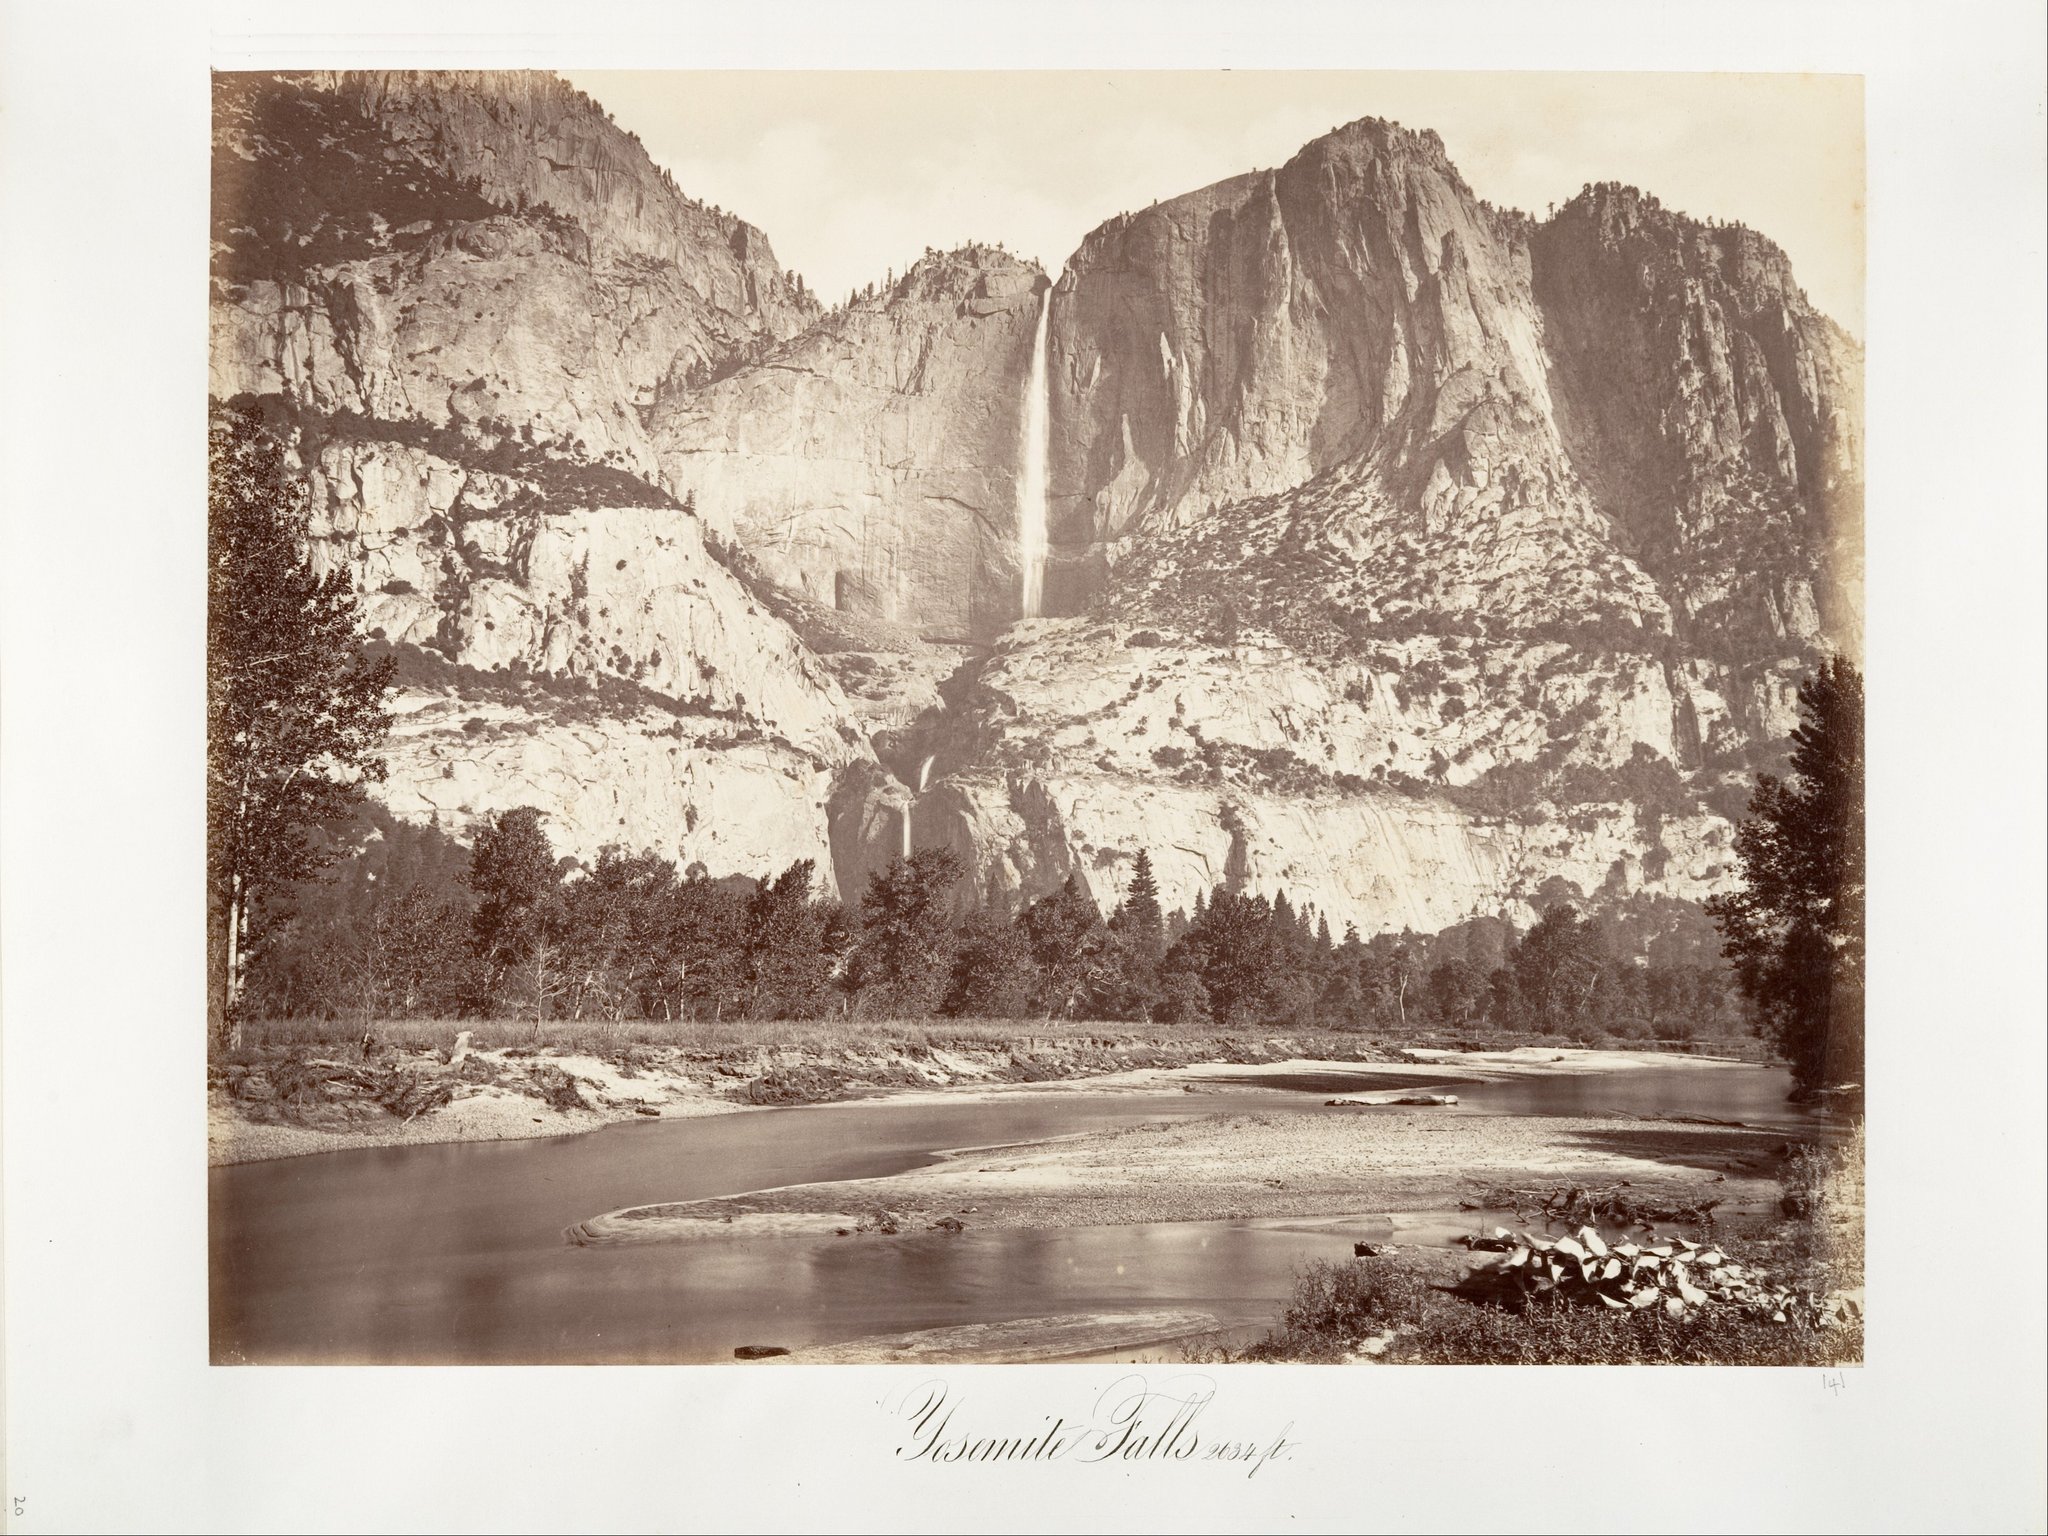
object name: photograph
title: Yosemite Falls, 2,634 feet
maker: carleton e. watkins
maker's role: artist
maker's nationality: american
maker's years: 1829-1916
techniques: albumen silver print, glass negative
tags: waterfalls,mountains,landscapes